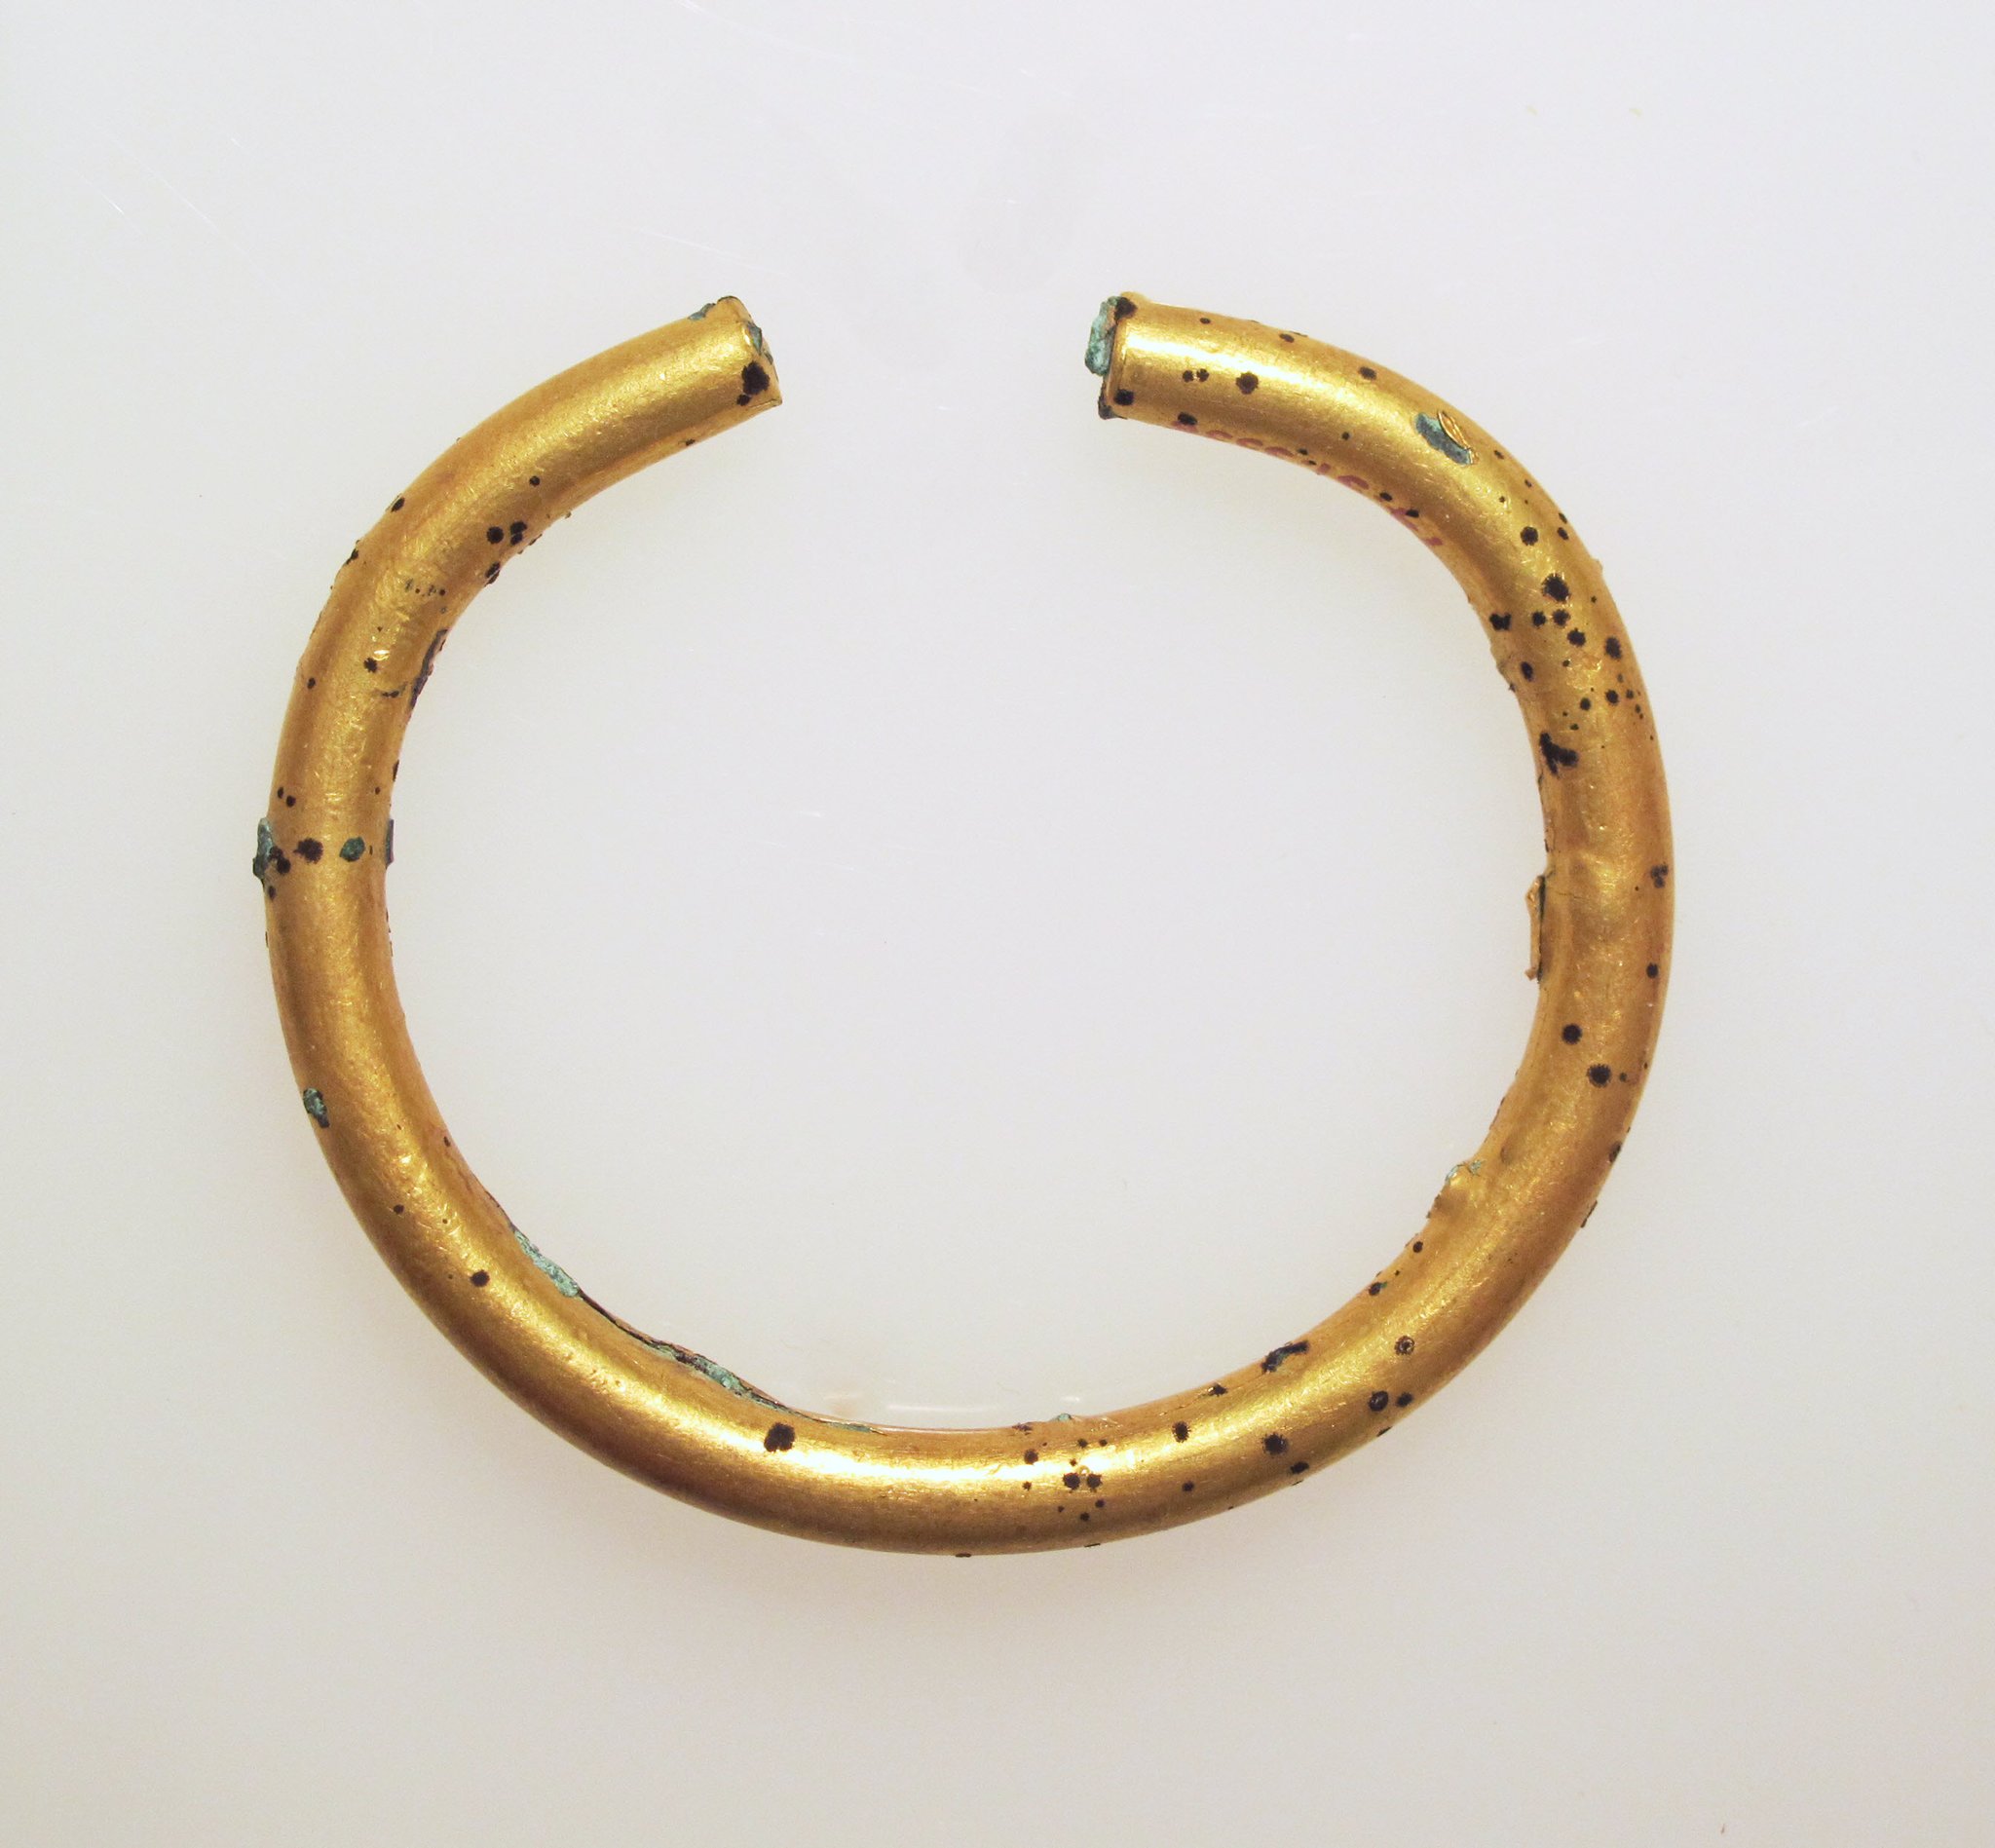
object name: bracelet, gilded bronze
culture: cypriot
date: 3900 BCE-100 CE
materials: bronze, gold